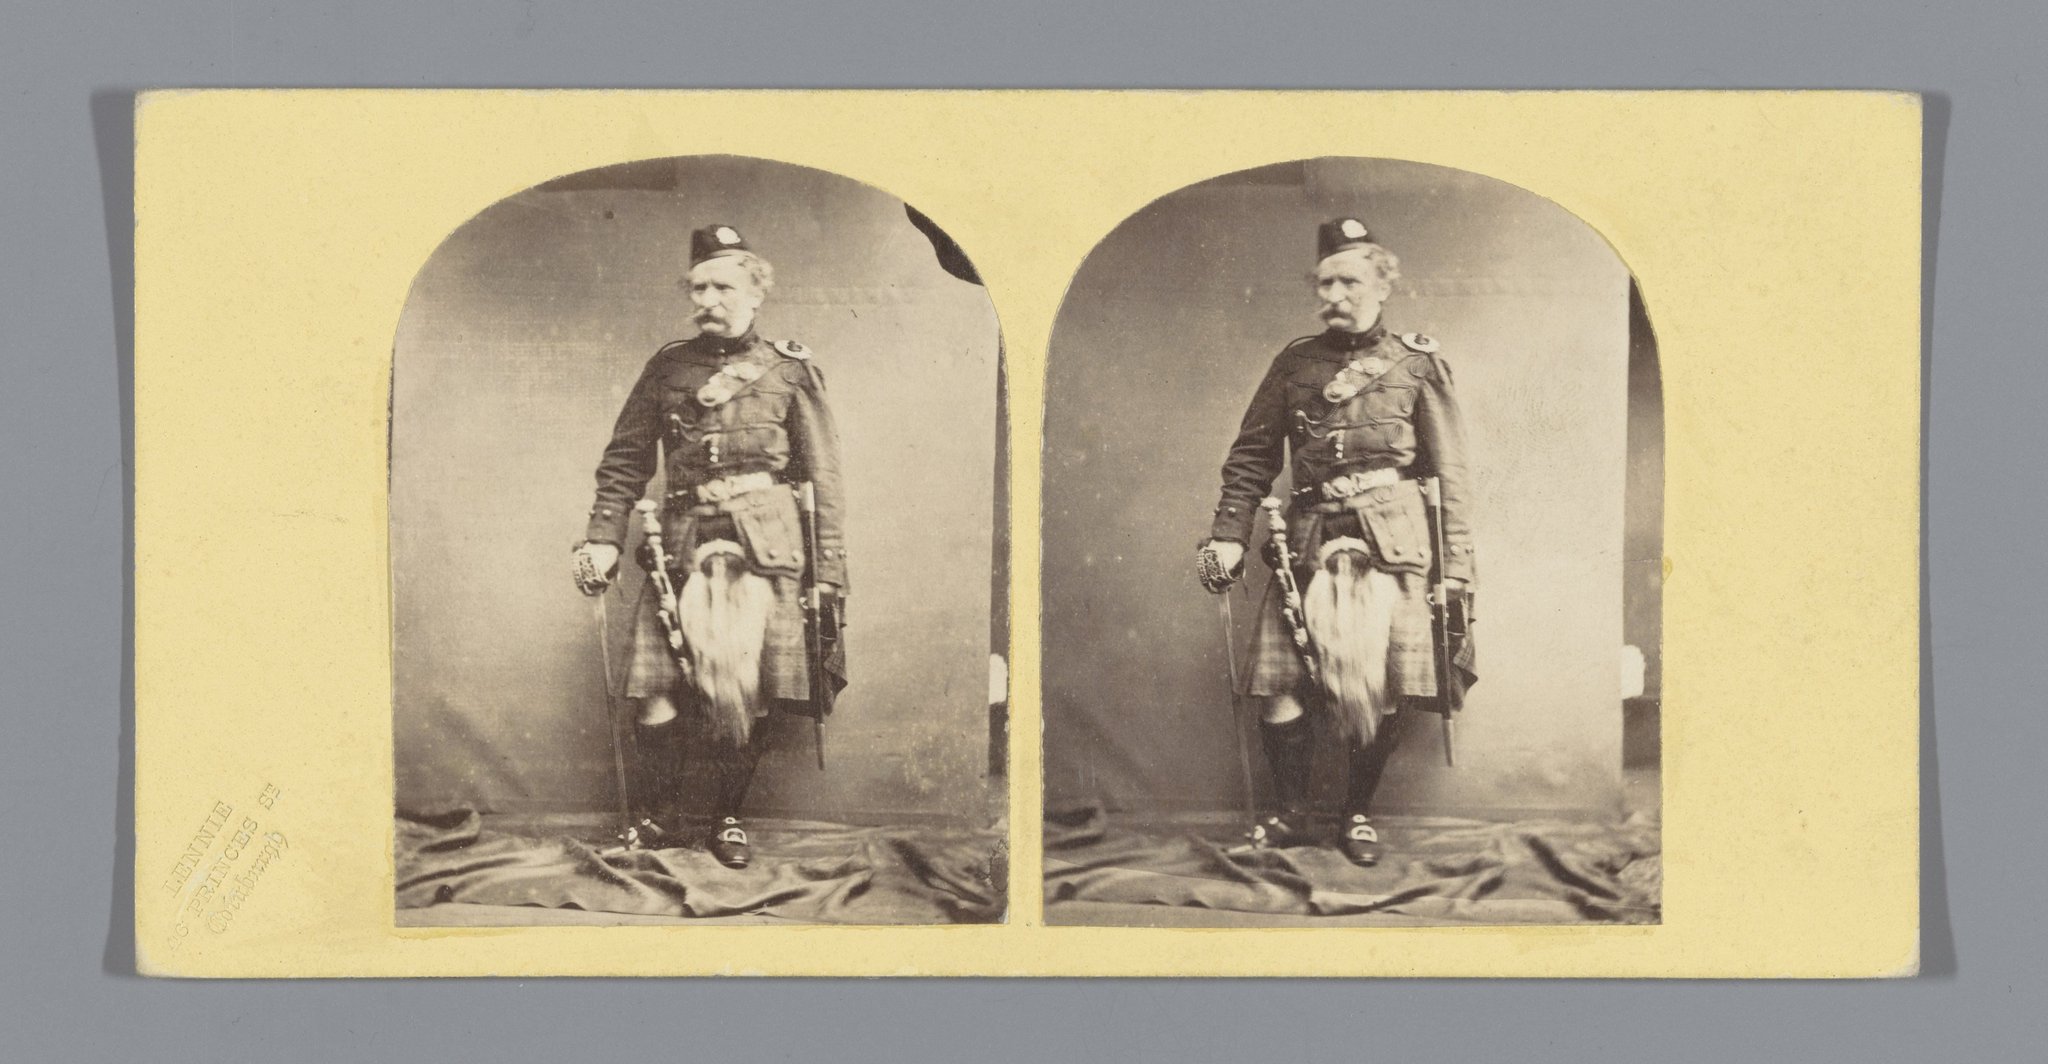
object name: stereograph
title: Hoofdman van de Schotse Hooglanden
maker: Anonymous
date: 1850-1880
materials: cardboard, photographic support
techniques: albumen print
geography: scotland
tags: old man, folk costume, regional costume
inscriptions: name: ‘Lennie 46 Princes Str Edinburgh’, inscription: ‘A Highland Chief’